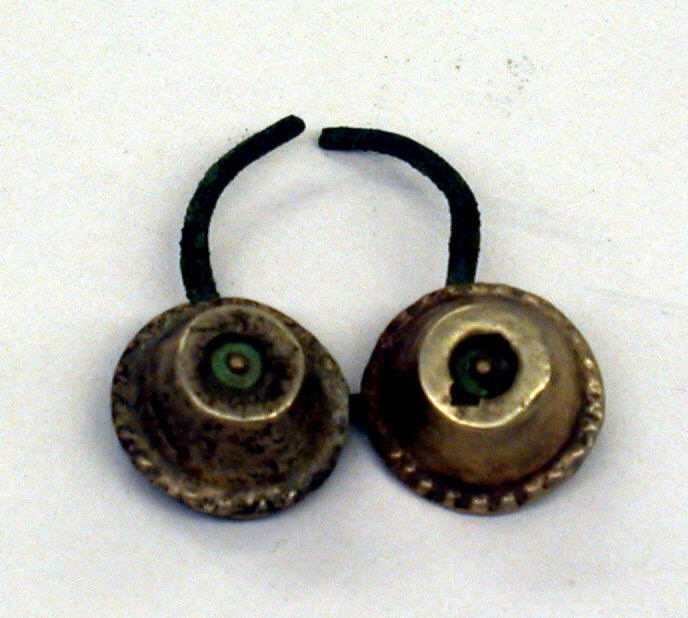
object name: nose ornament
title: Gold Nose Ornament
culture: moche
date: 501-700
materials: gold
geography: peru